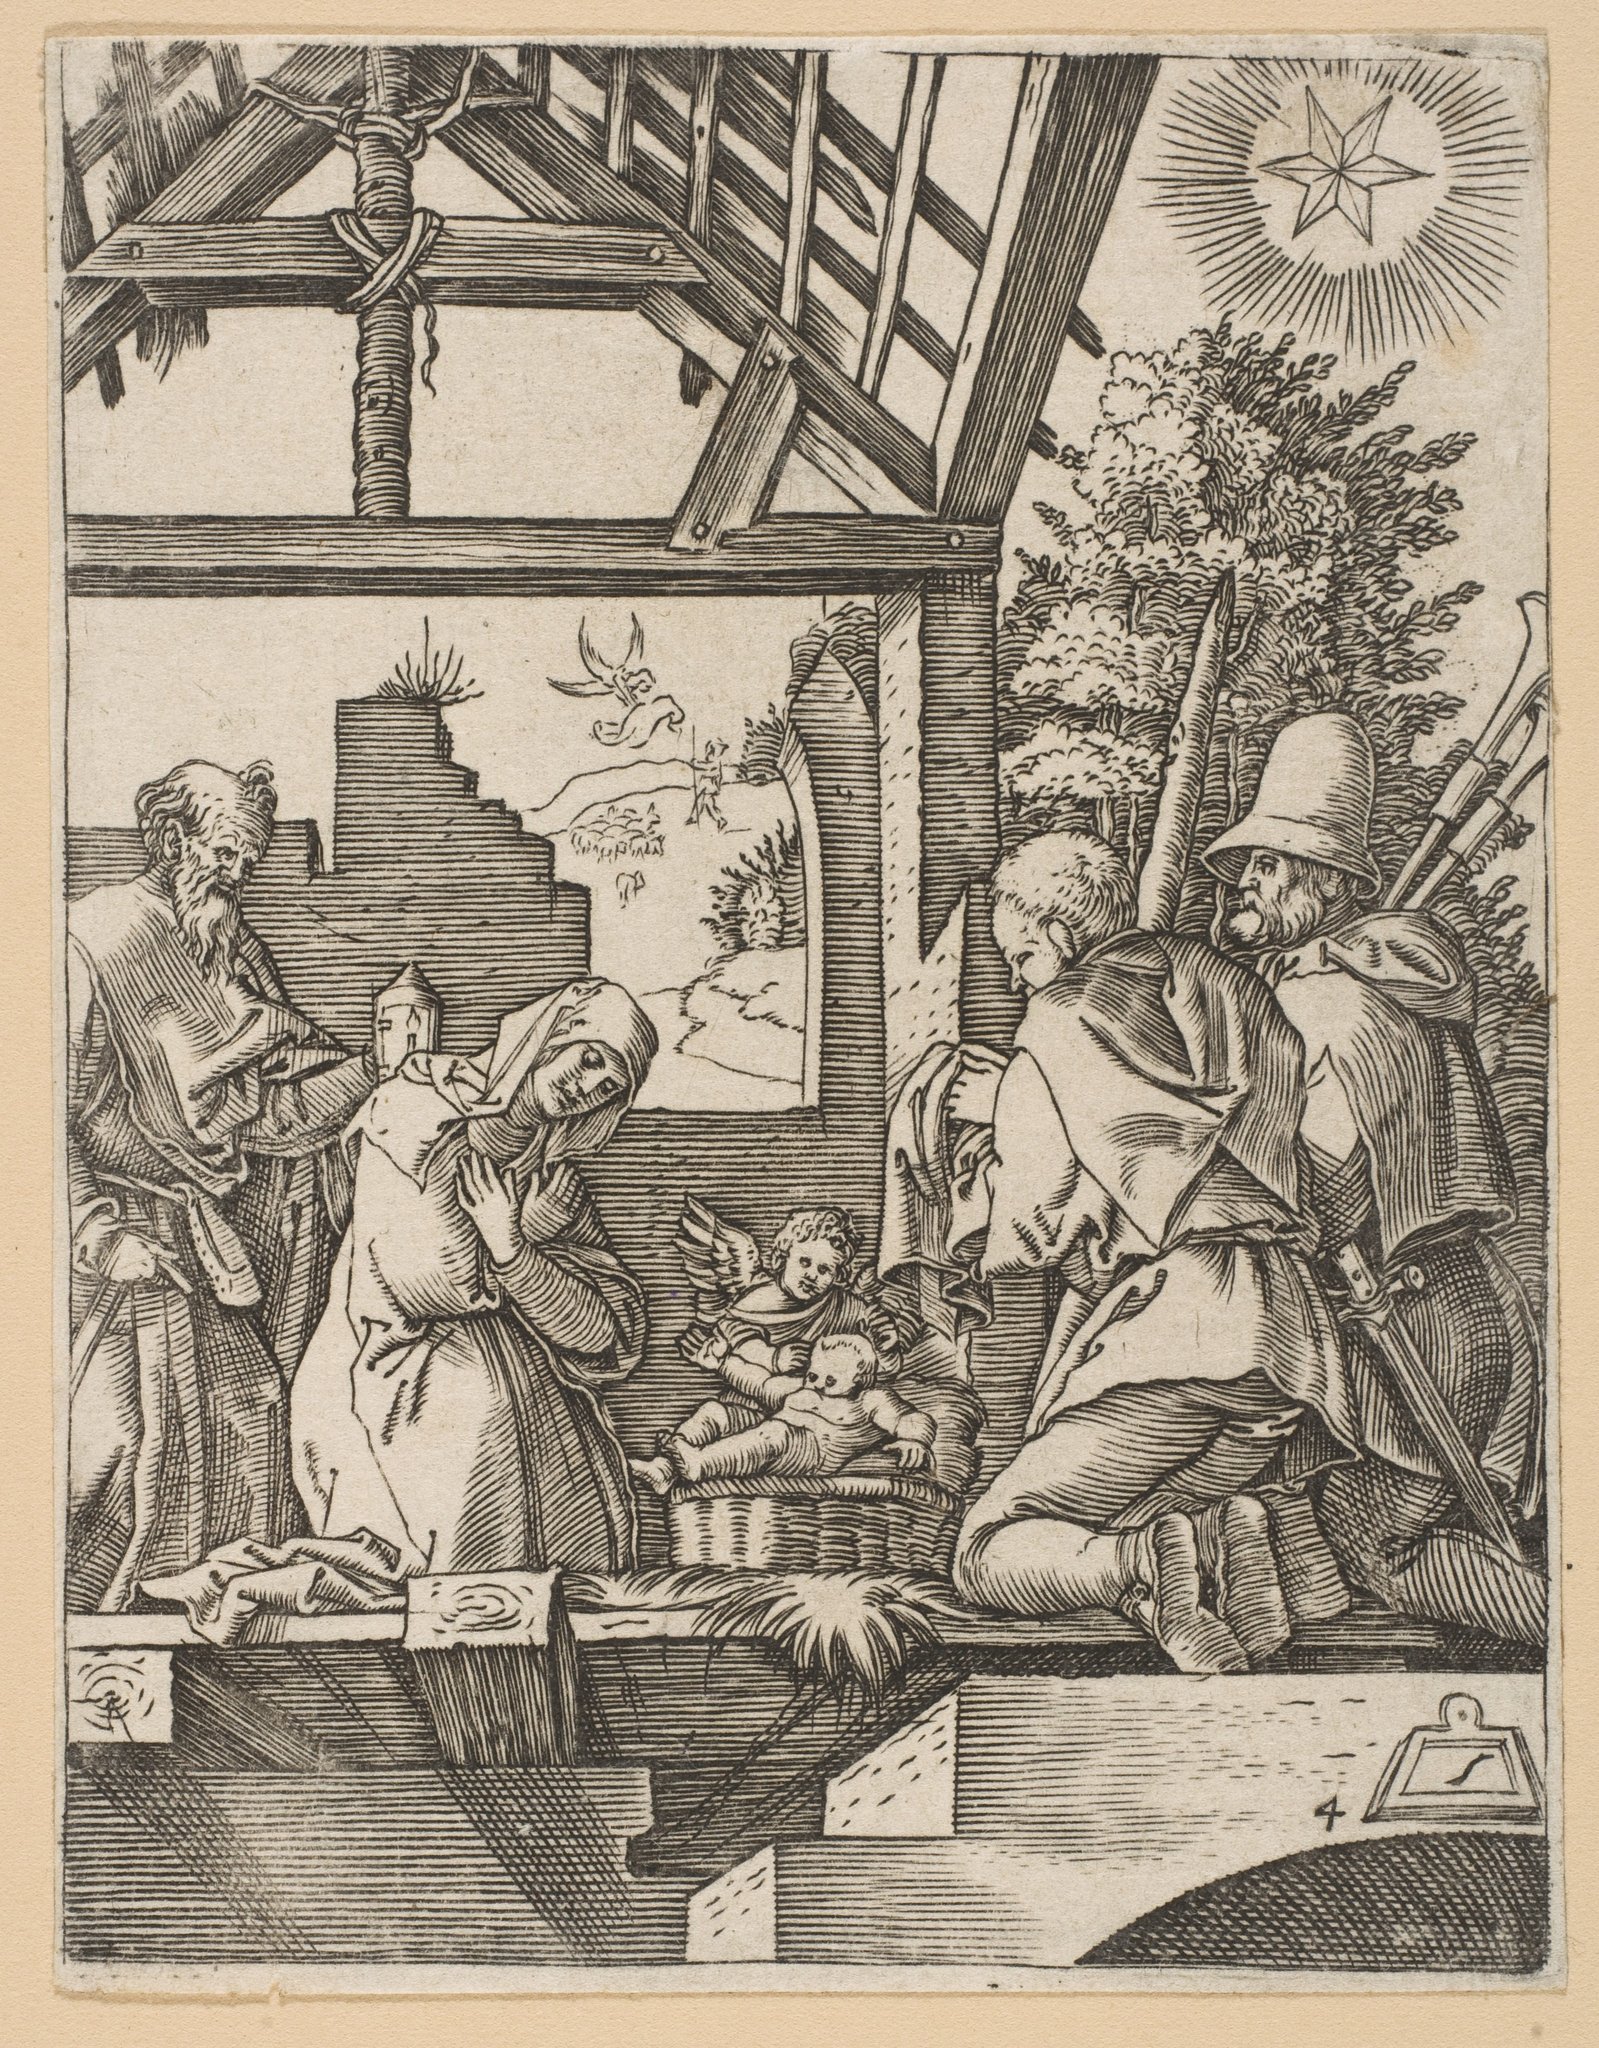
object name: print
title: The Nativity (copy)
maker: marcantonio raimondi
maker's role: artist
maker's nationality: italian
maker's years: 1475-1534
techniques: engraving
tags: angels,virgin mary,jesus,nativity